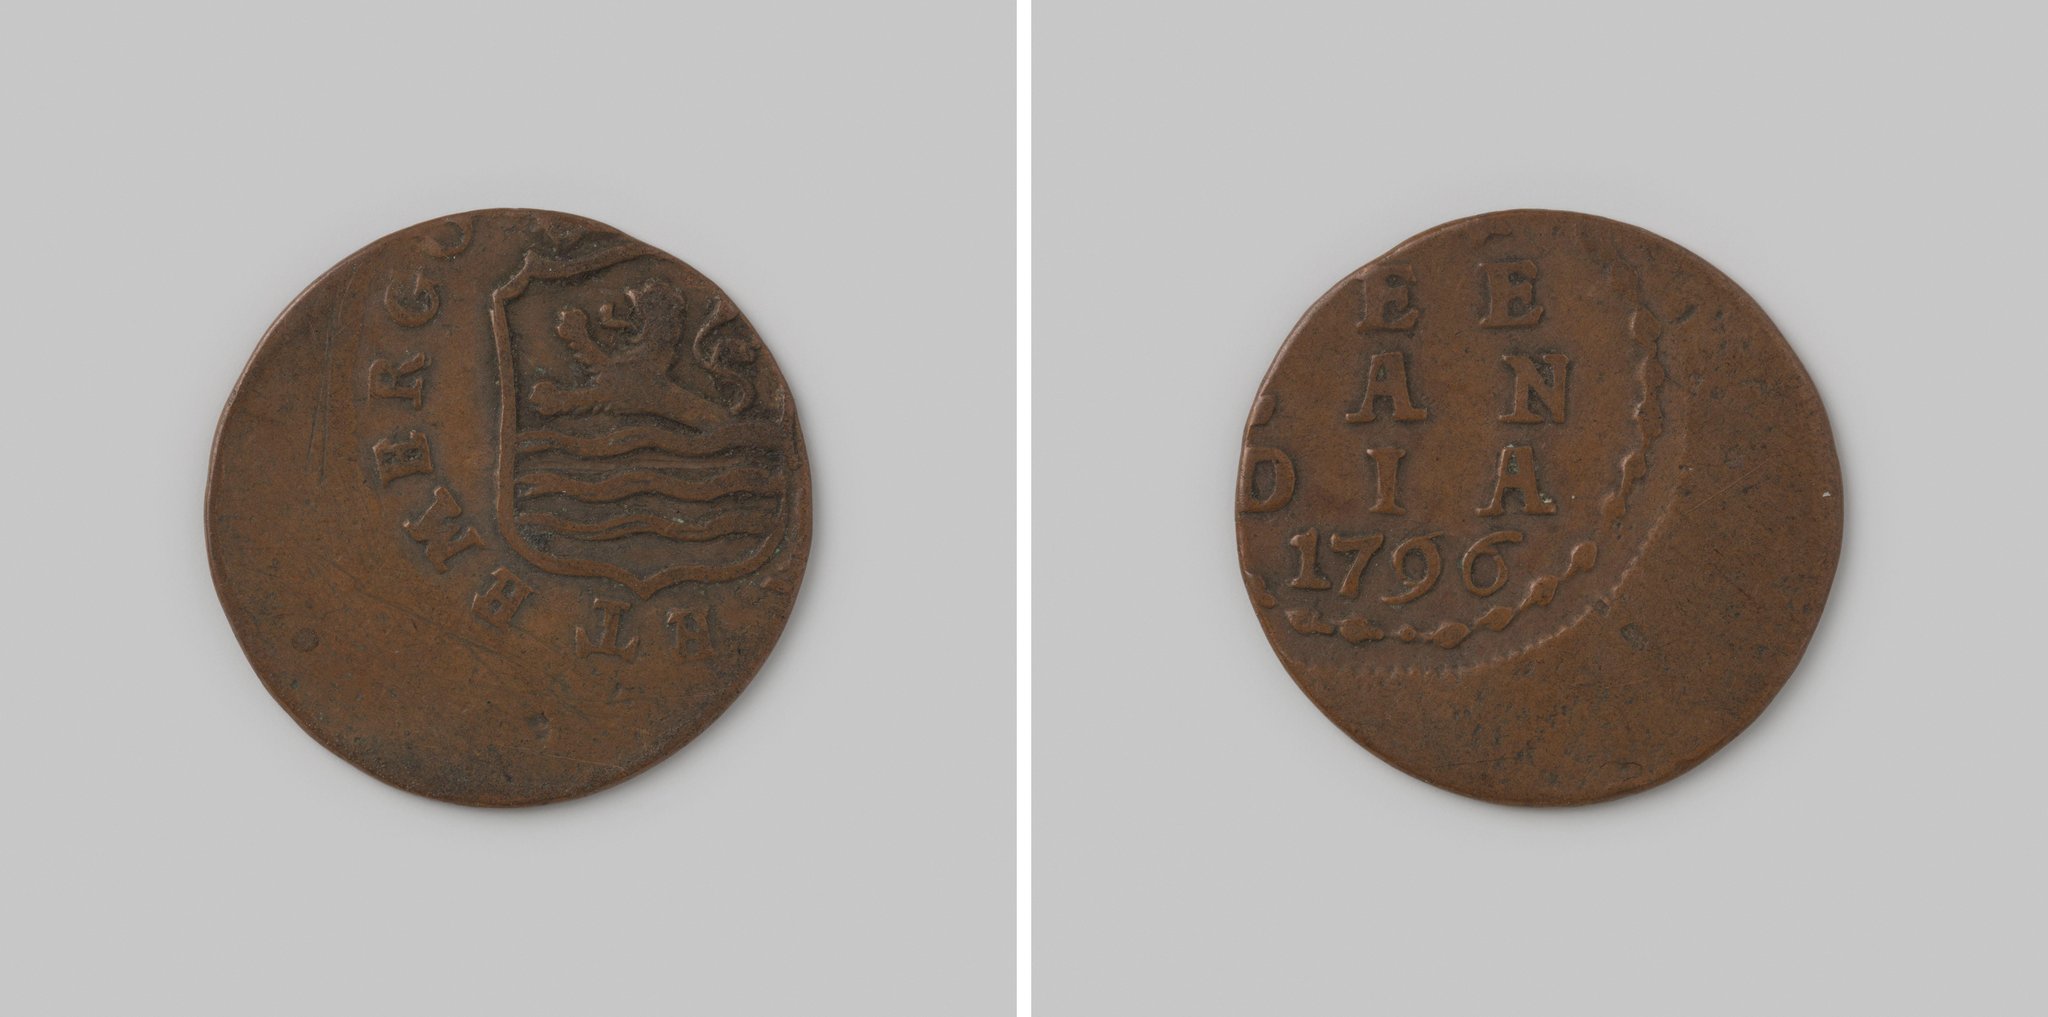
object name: coin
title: Bataafse Republiek, duit op naam van Zeeland, 1796, misslag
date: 1796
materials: copper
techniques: striking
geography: middelburg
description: Koperen munt. Voorzijde: gedeelte van gekroond, zijdelings ingedeukt wapenschild van Zeeland met gedeelte van omschrift. Keerzijde: in eengedeelte van een krans gedeeltelijk opschrift in drie regels, waaronder jaartal.